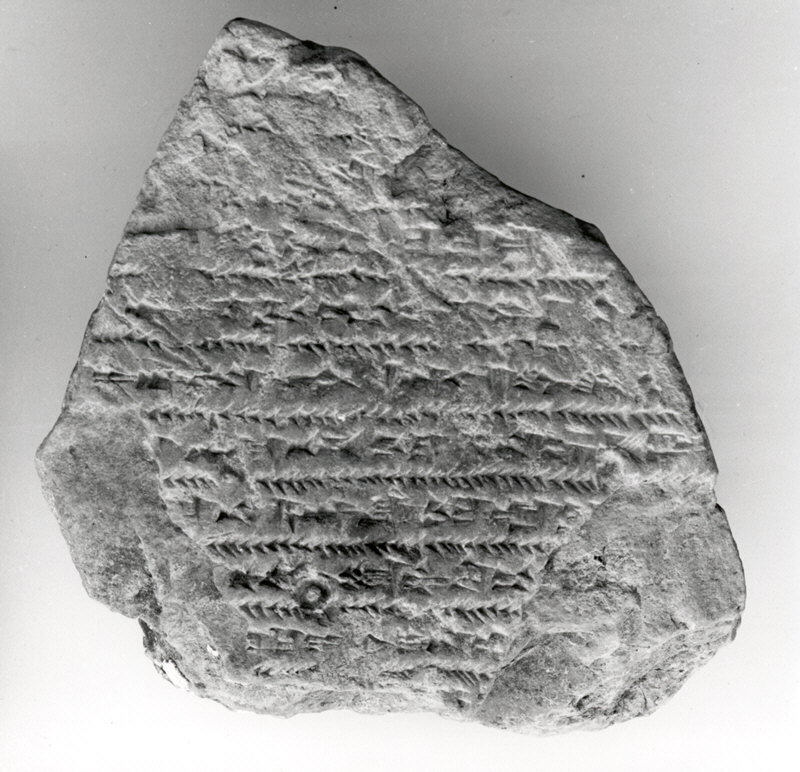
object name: cuneiform tablet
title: Cuneiform tablet: school exercise tablet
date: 333-1 BCE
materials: clay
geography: mesopotamia